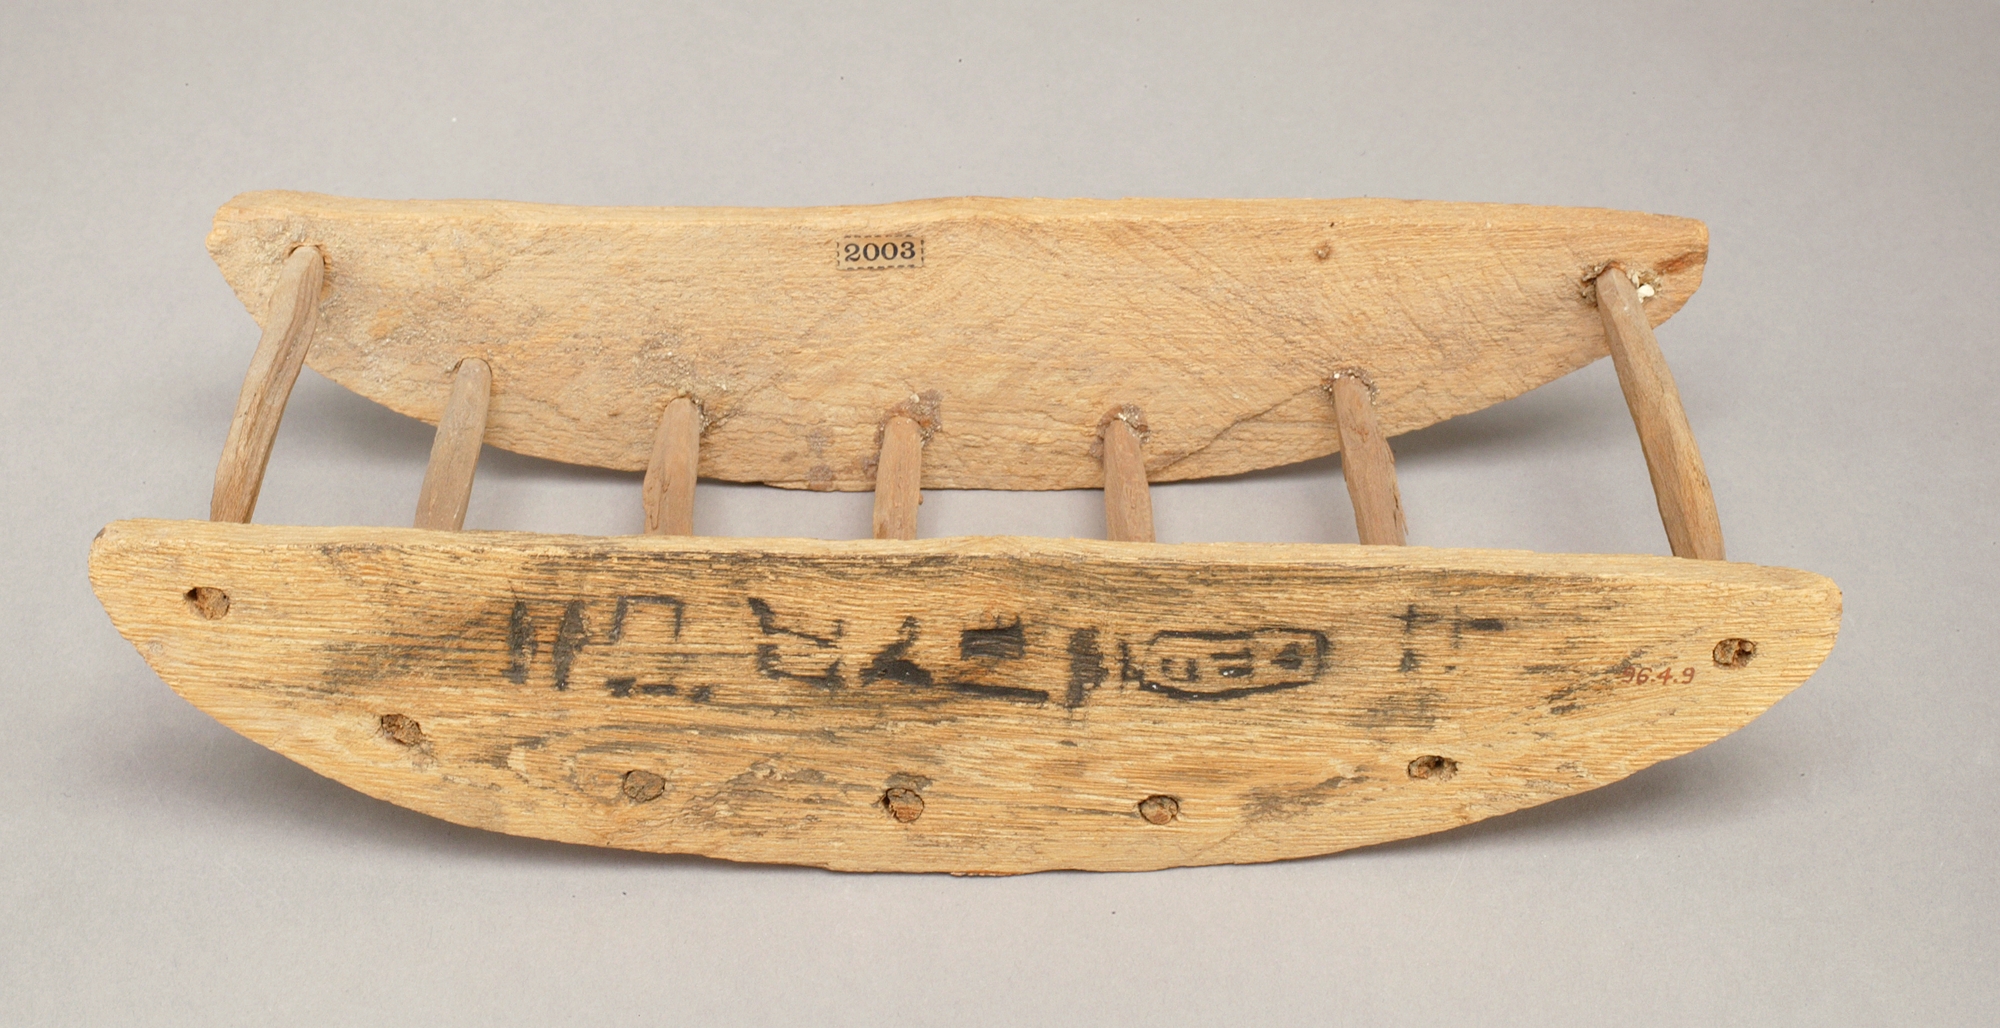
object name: rocker model, hatshepsut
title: Model Stone Rocker from a Foundation Deposit for Hatshepsut's Temple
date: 1479-1458 BCE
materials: ink, wood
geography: egypt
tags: hieroglyphs